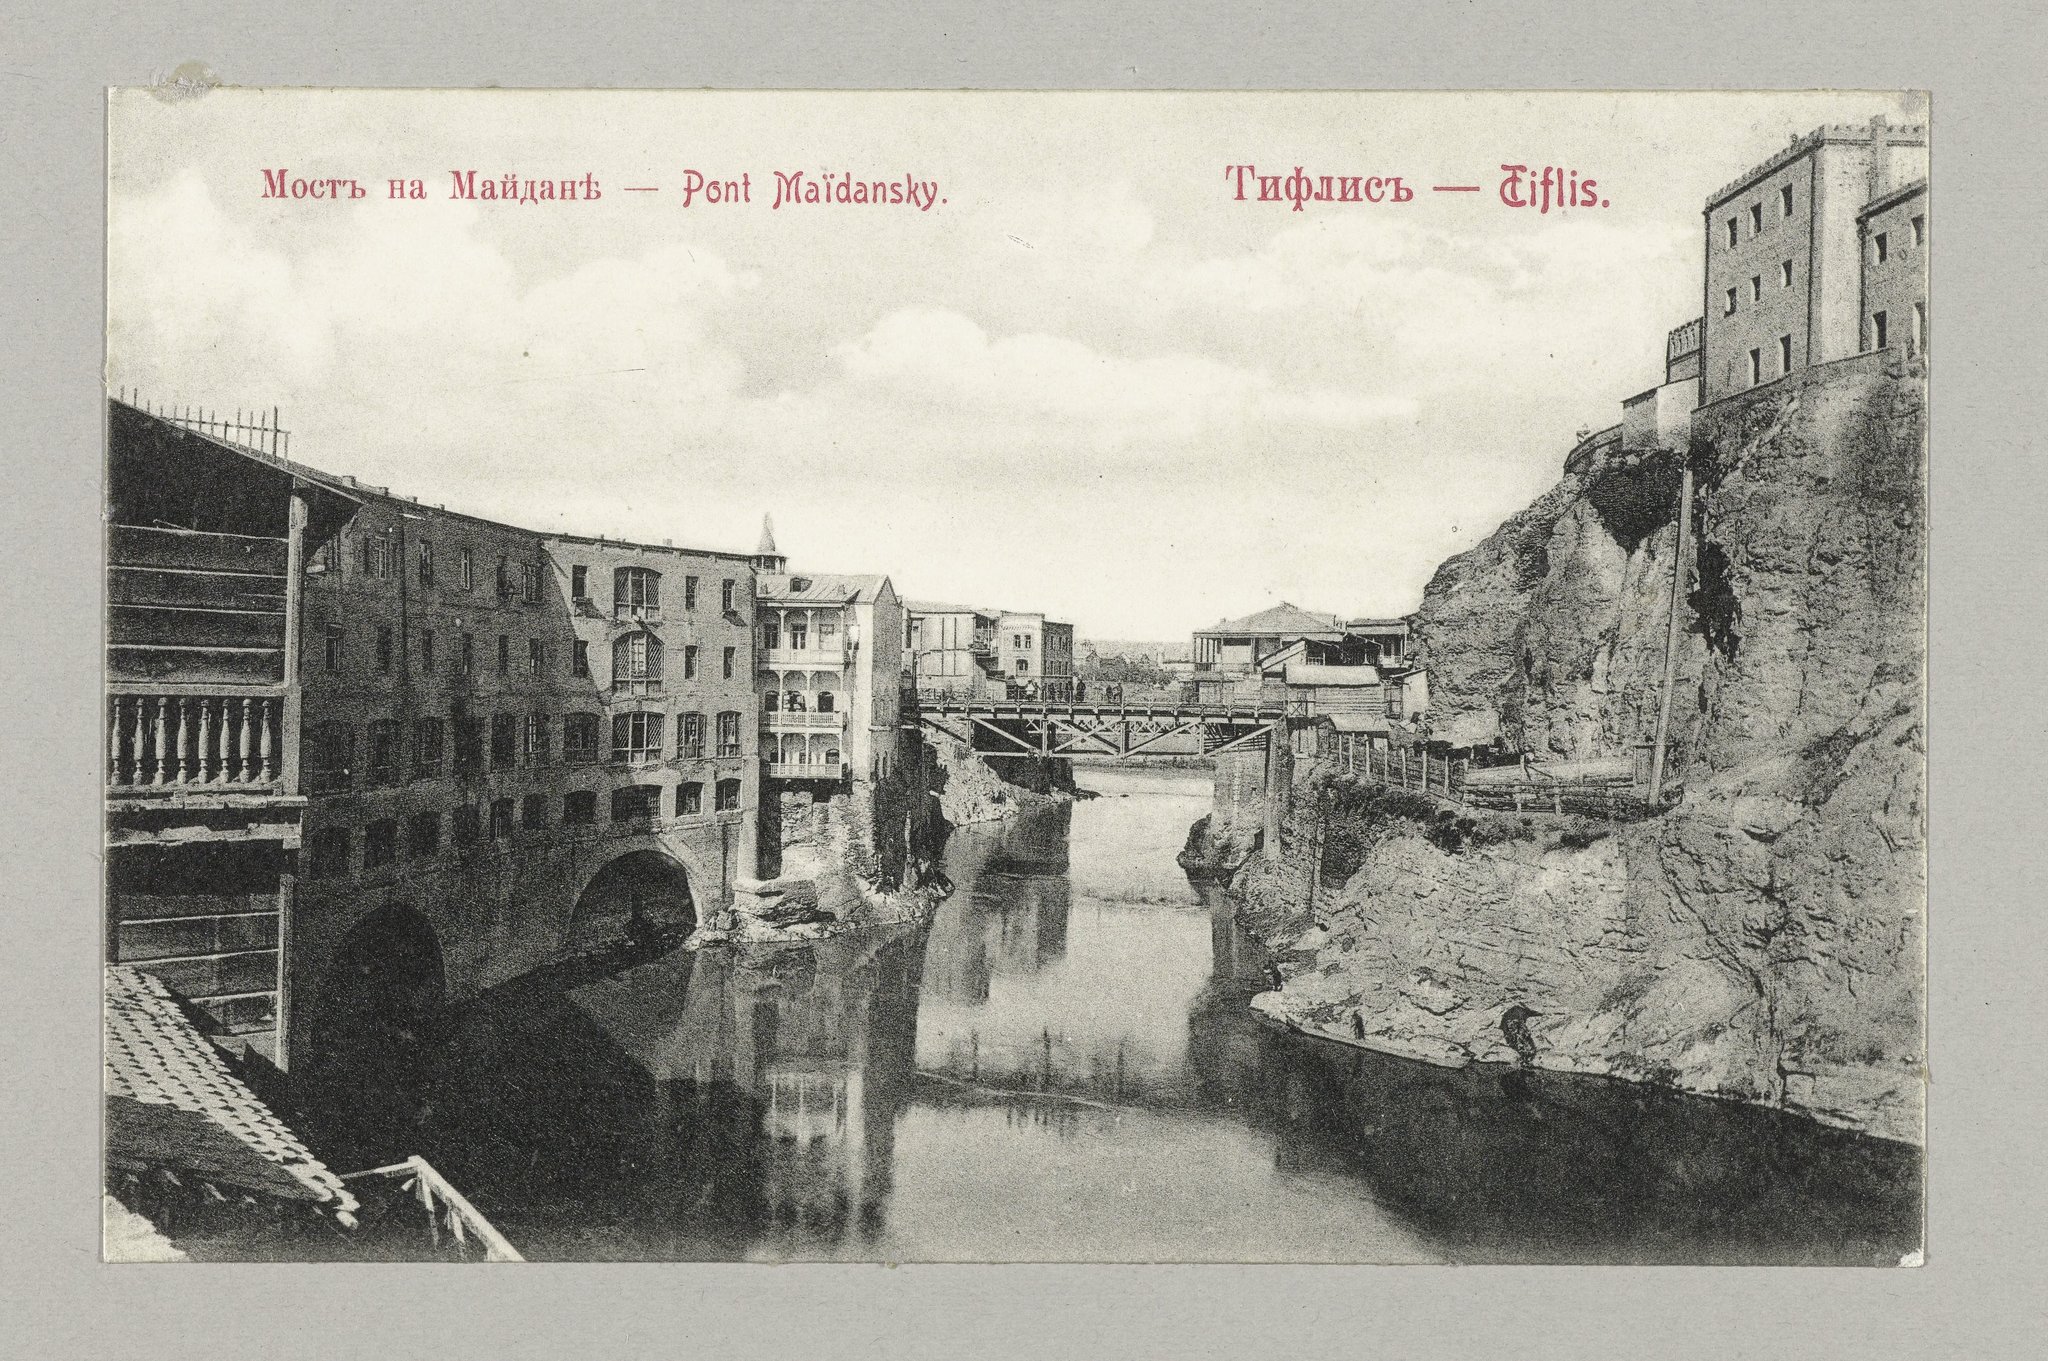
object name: photomechanical print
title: Maïdanskybrug van veraf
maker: Anonymous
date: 1895-1915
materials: cardboard, paper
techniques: photograph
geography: tbilisi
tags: tbilisi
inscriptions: number: ‘30.’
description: Bovenaan staat de titel in het Russisch en Frans weergegeven.